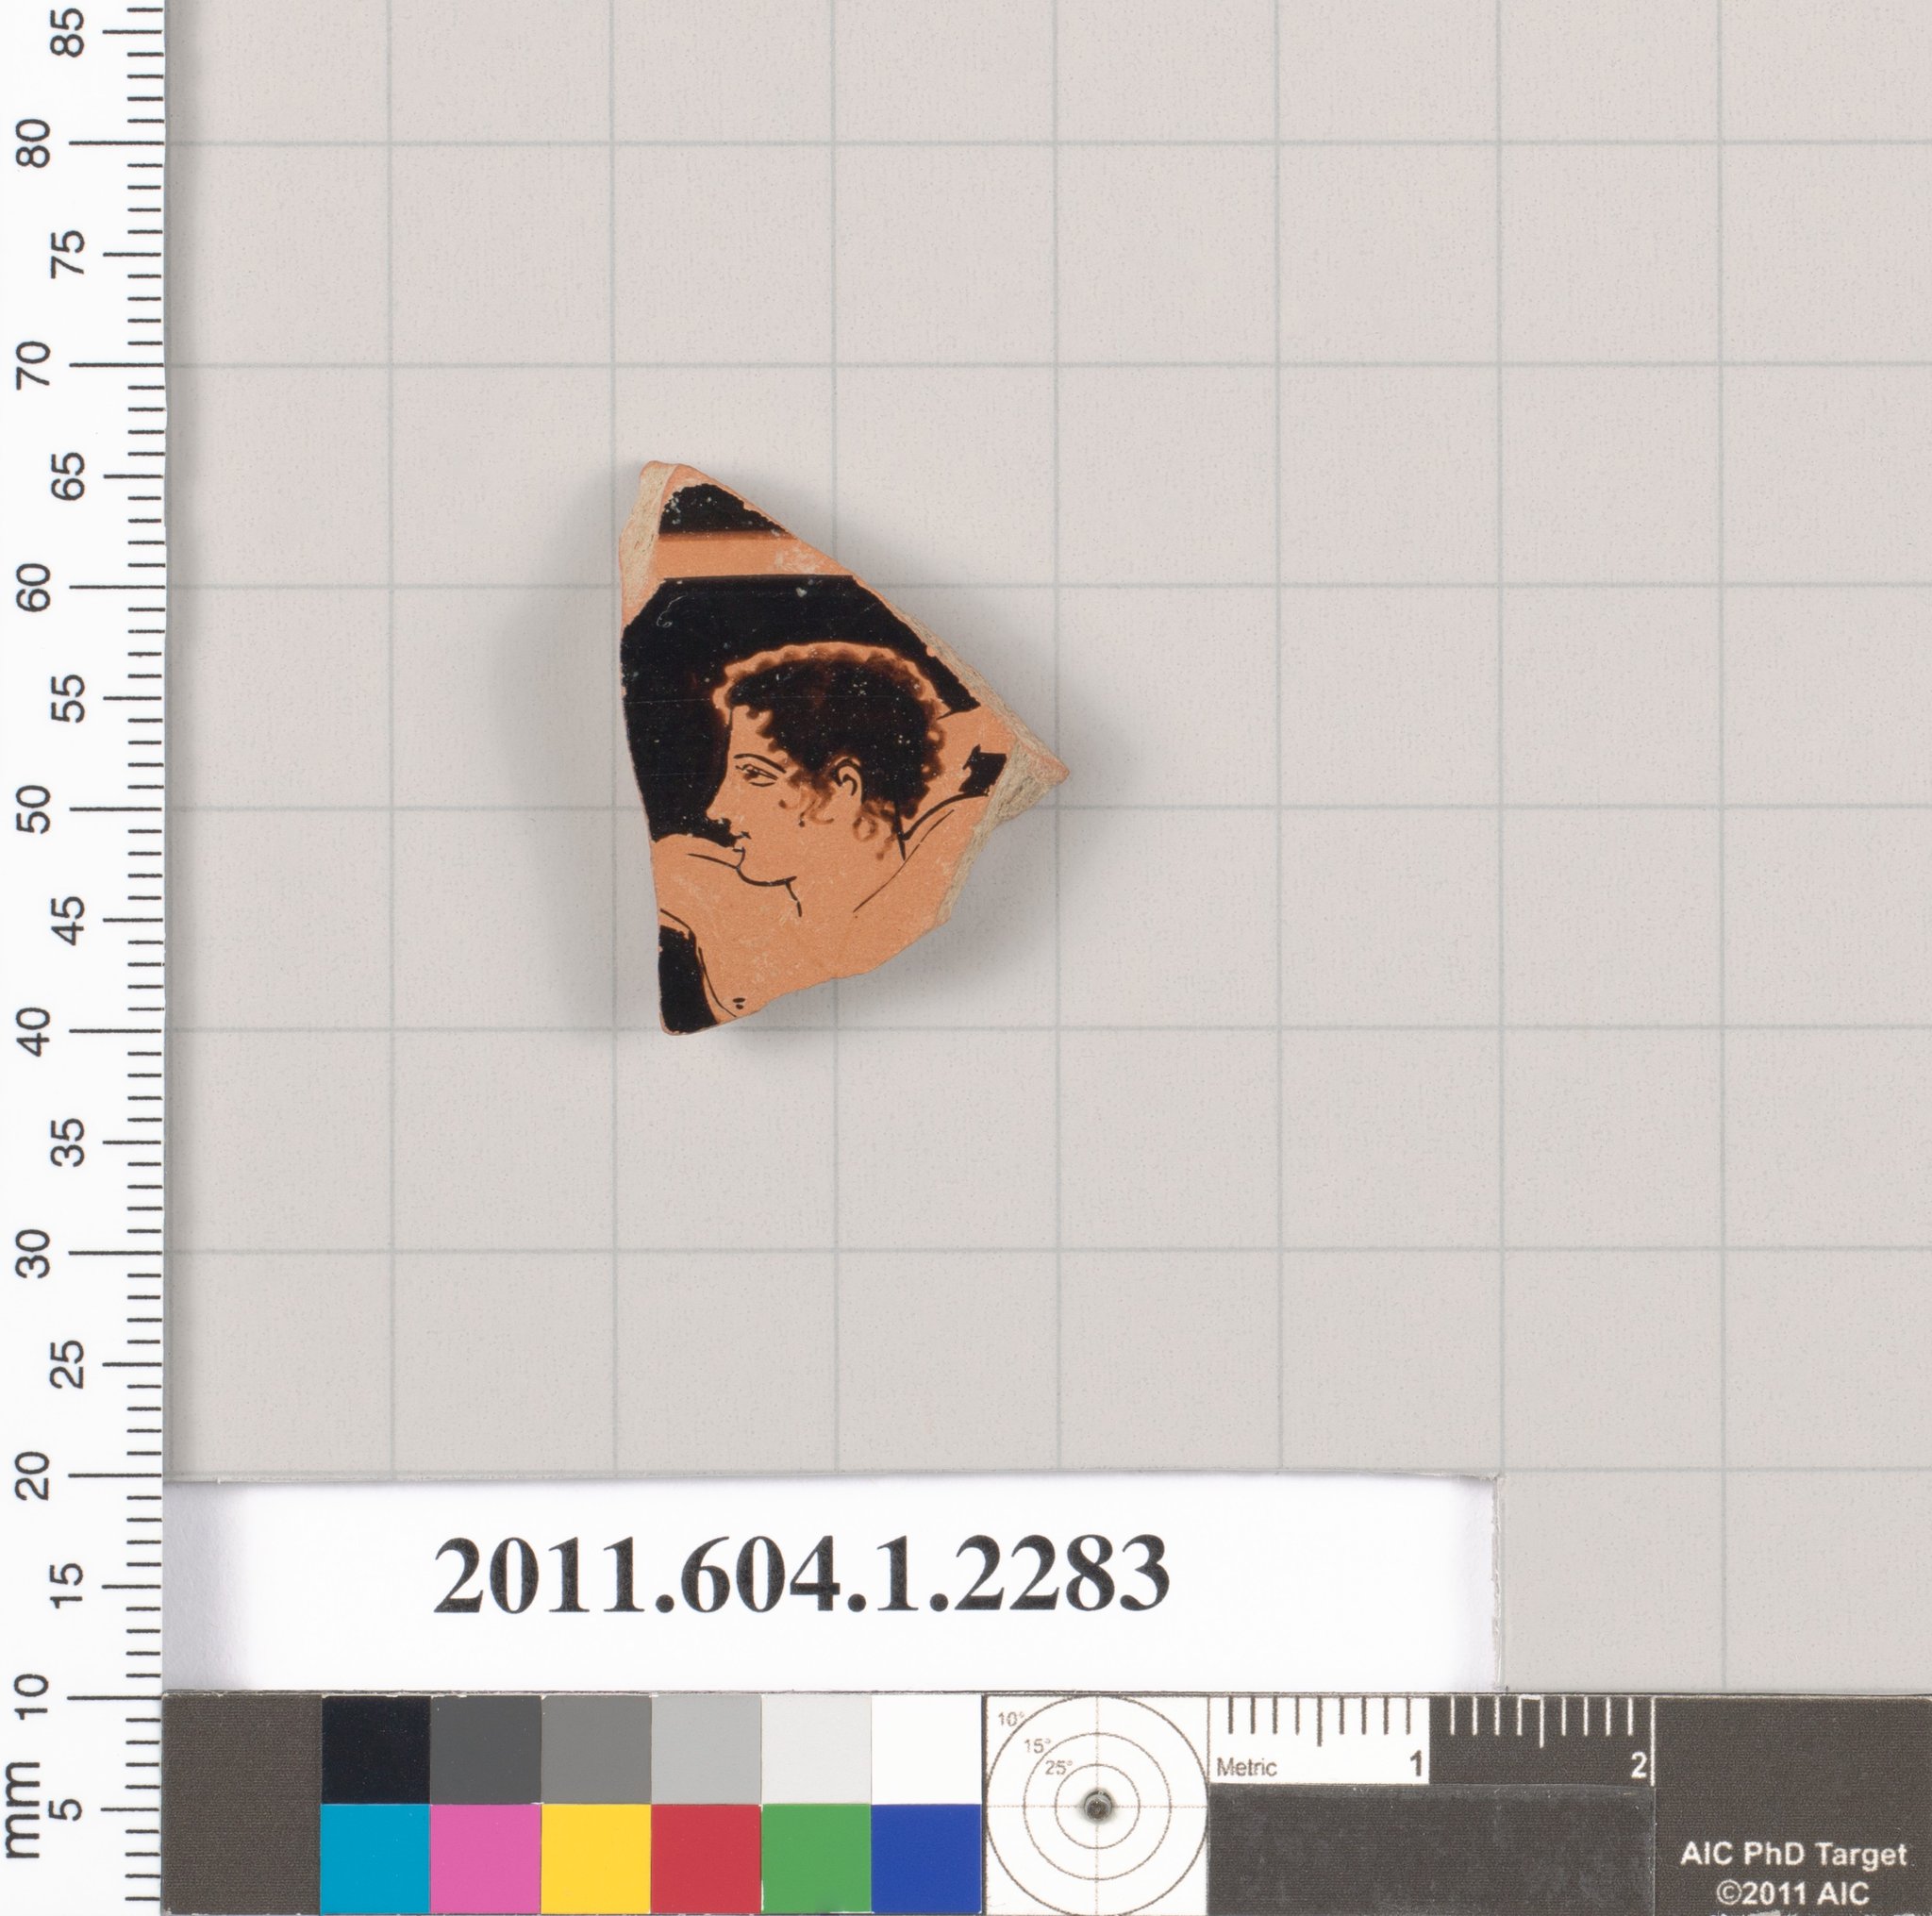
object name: kylix fragment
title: Terracotta fragment of a kylix (drinking cup)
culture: greek, attic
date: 475-451 BCE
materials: terracotta